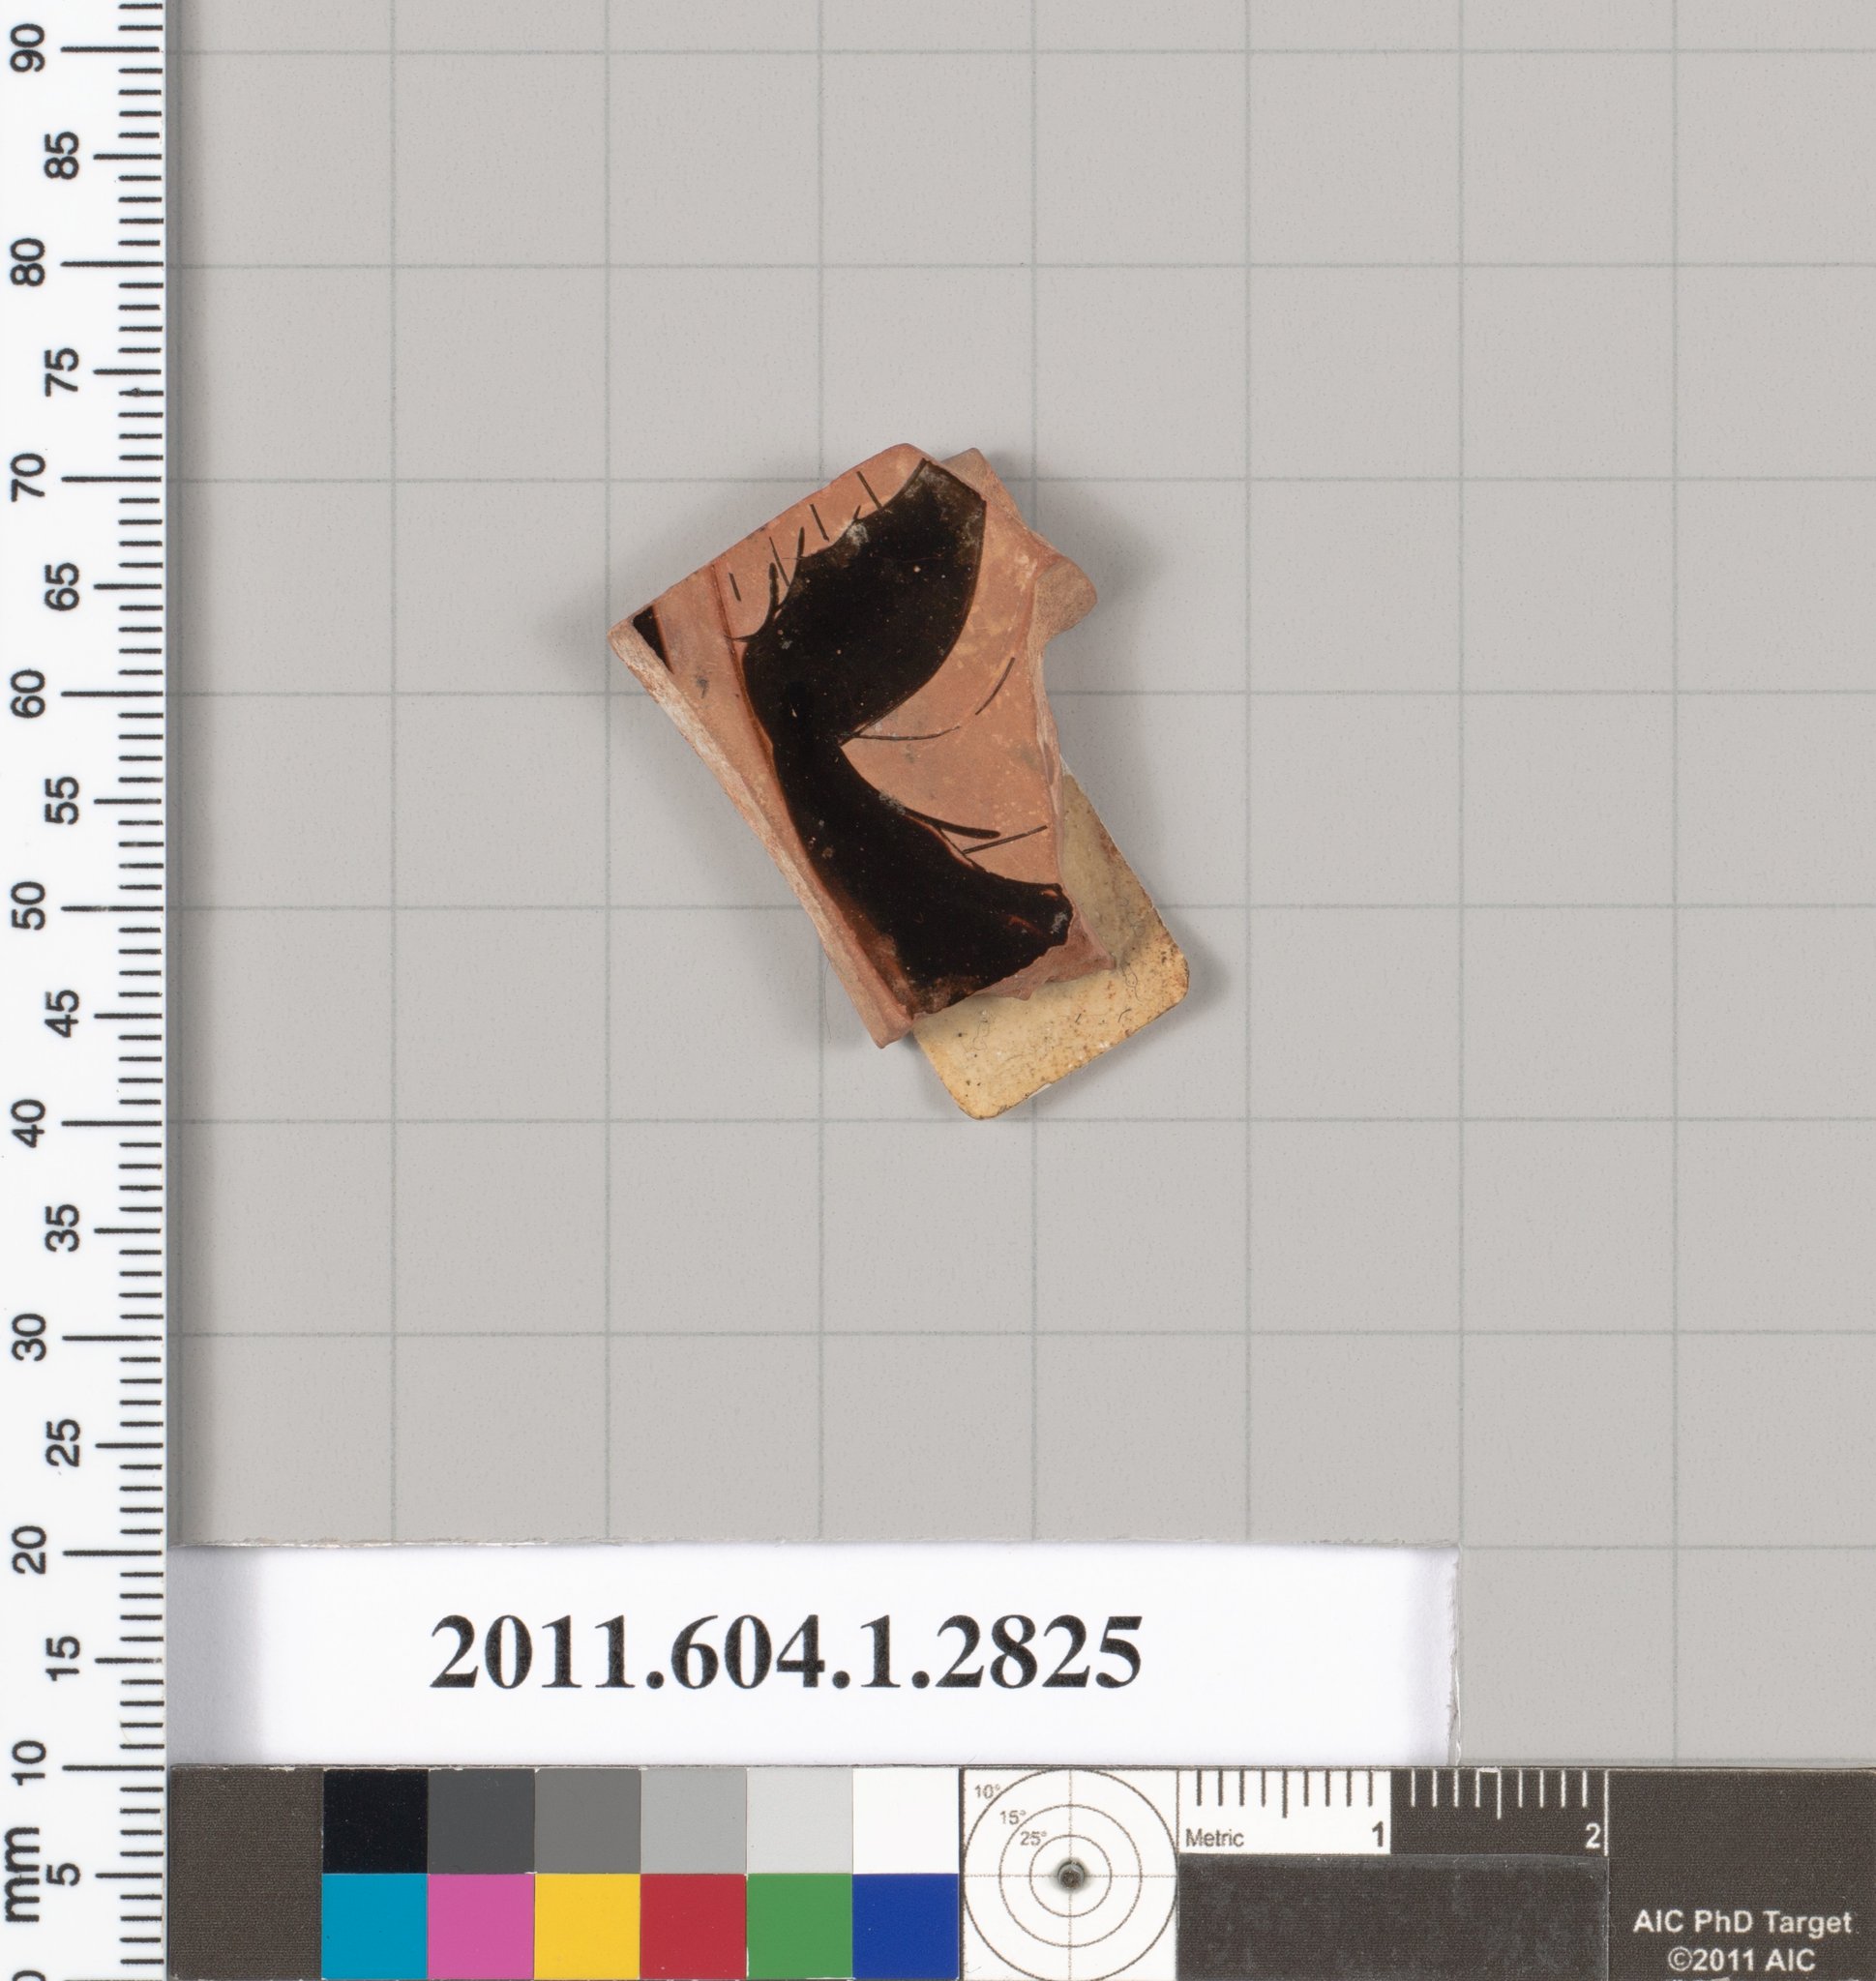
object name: kylix fragment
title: Terracotta fragment of a kylix (drinking cup)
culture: greek, attic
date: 475-451 BCE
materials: terracotta